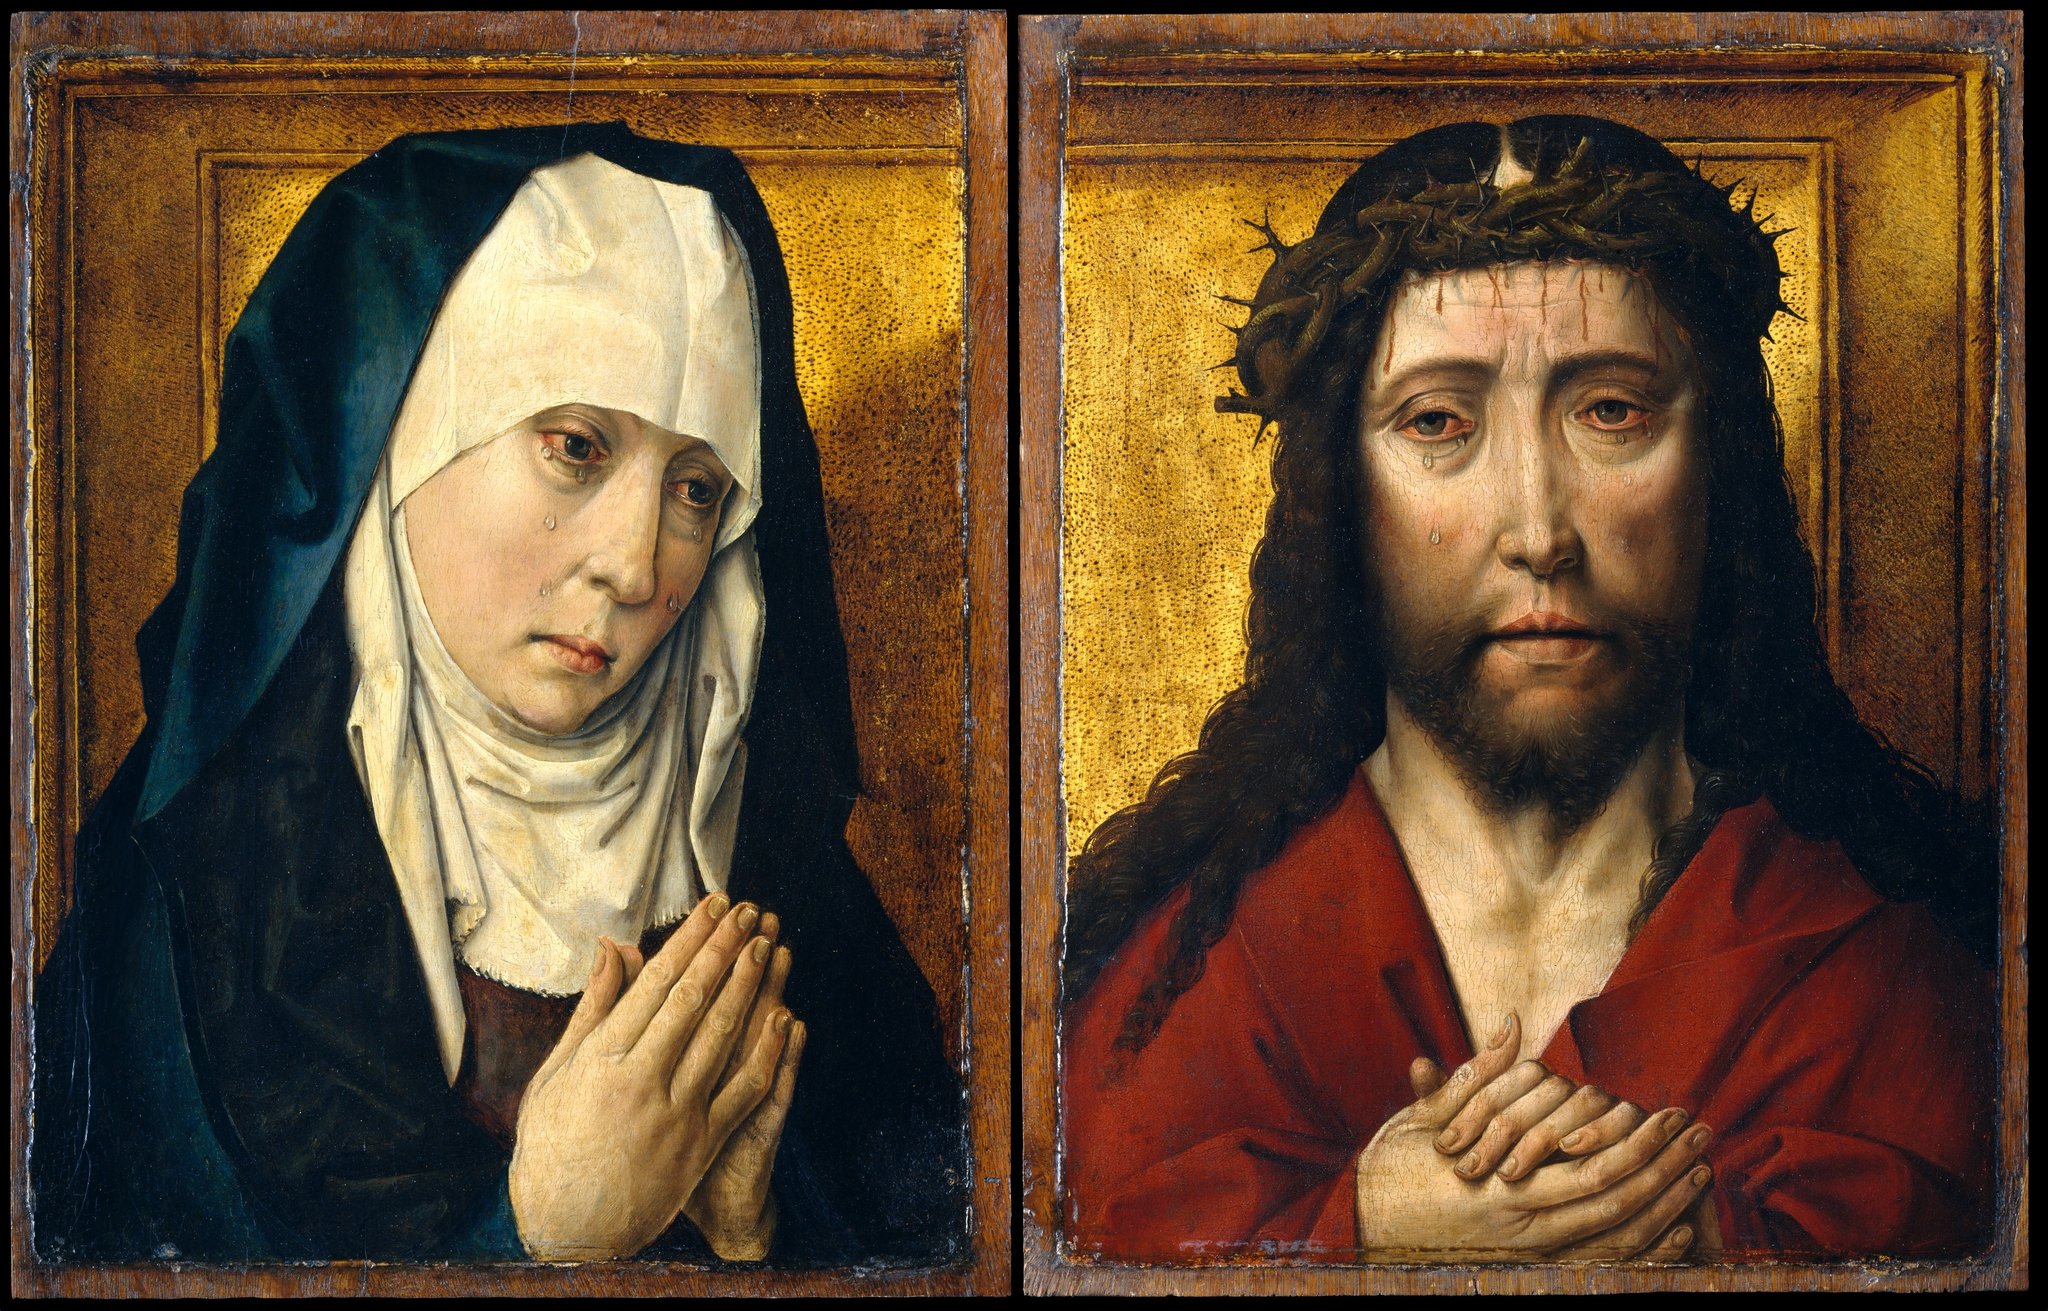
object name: painting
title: The Mourning Virgin; Christ Crowned with Thorns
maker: dieric bouts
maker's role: artist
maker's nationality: netherlandish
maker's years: 1457-1475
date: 1520-1530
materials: wood, oil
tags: sadness,christ,virgin mary